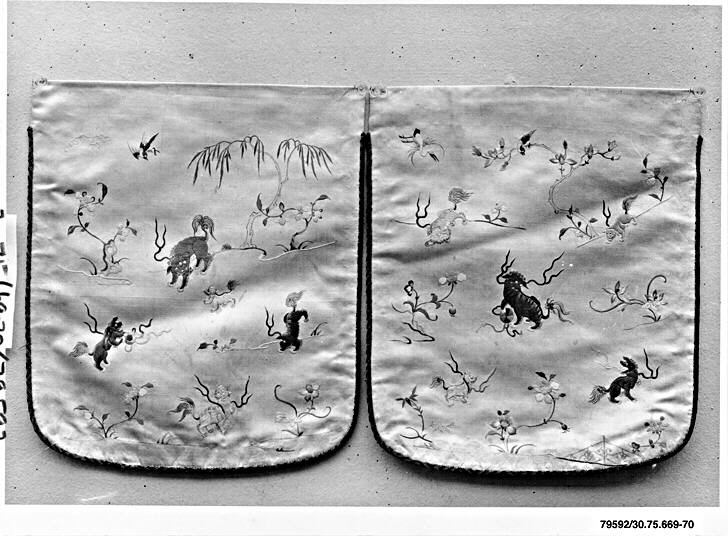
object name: tab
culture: chinese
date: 1644-1911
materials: silk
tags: animals,birds,flowers